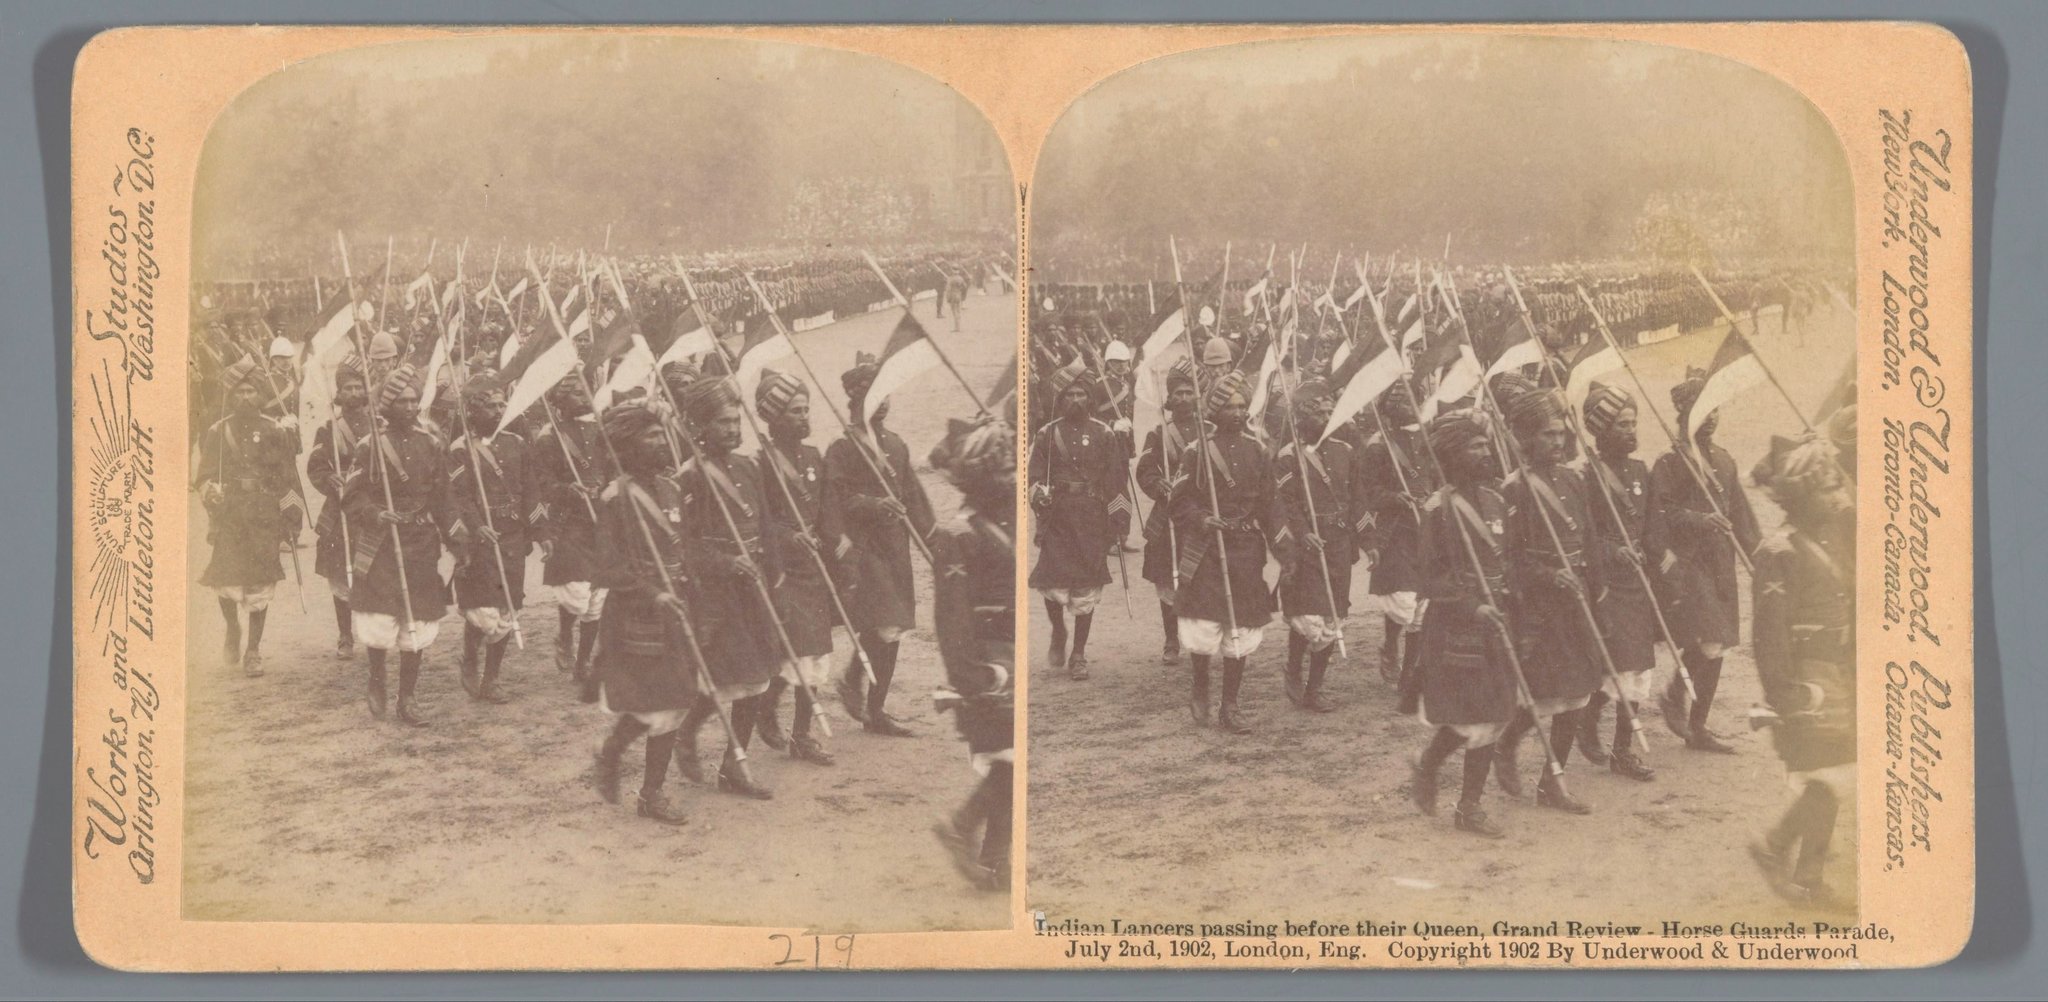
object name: stereograph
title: Indian Lancers passing before their Queen, Grand Review - Horse Guards Parade, July 2nd, London, Eng.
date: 1902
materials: cardboard, photographic support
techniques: albumen print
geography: london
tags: military parade, pageant, london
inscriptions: name: ‘Works and Studios Sun Sculpture trade mark Arlington N.J. Littleton N.H. Washington D.C.’, number: ‘219’